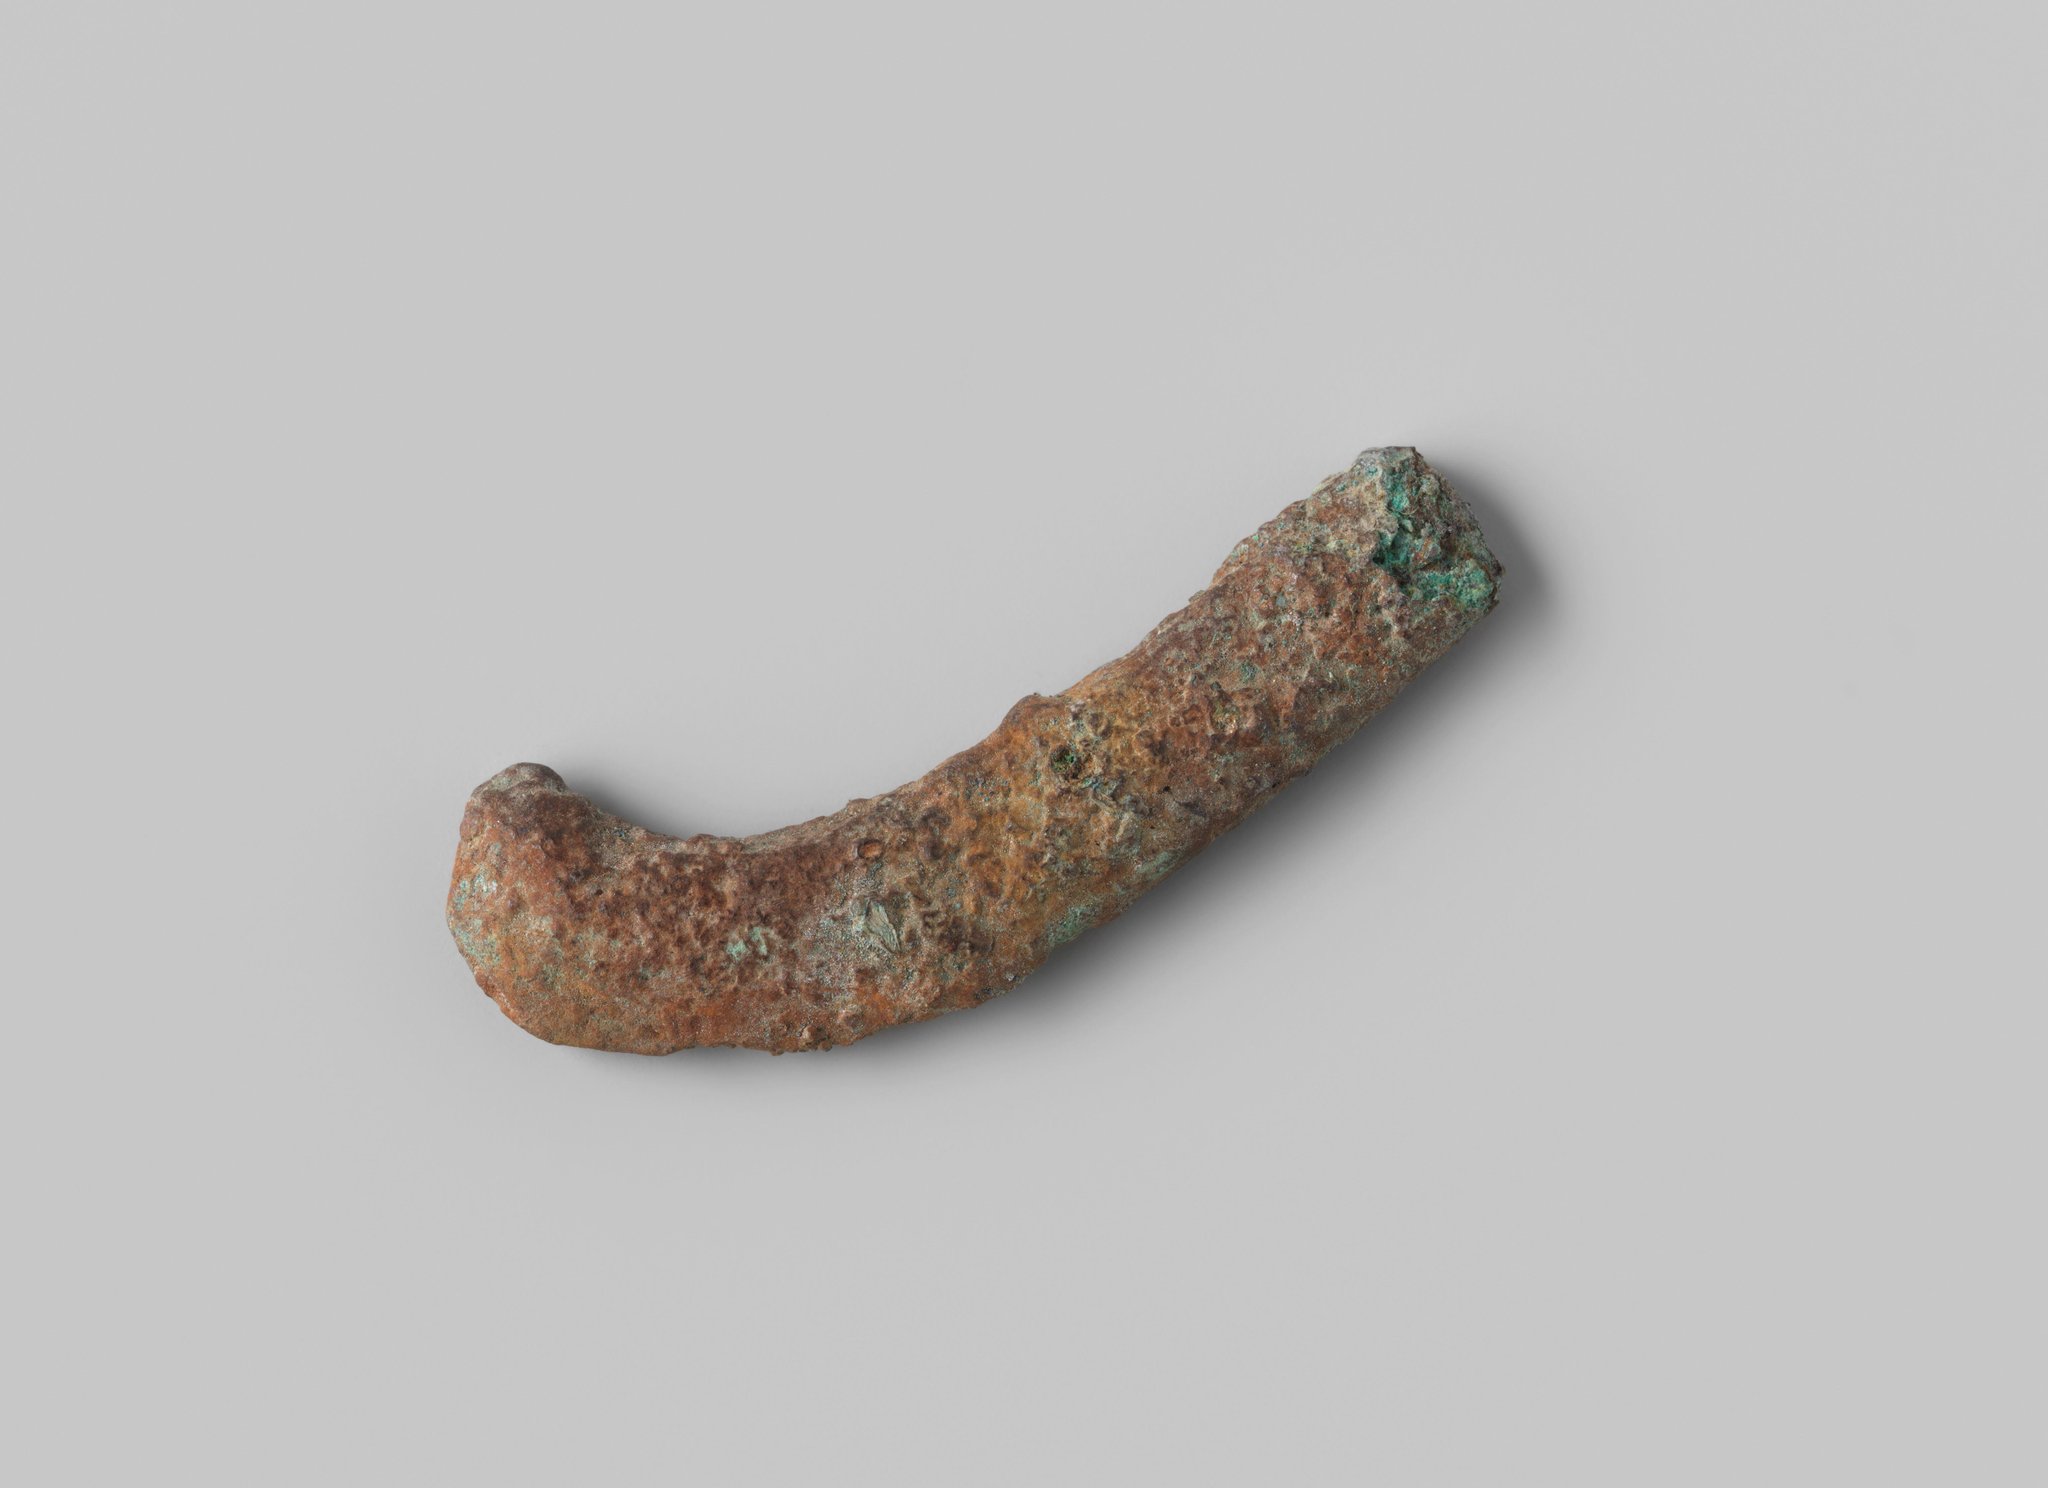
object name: belt buckle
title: Fragment riemgesp uit het wrak van de Oost-Indiëvaarder Hollandia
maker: Anonymous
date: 1700-1743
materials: copper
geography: netherlands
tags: verenigde oostindische compagnie, hollandia (schip), annet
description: Rectangular, fragm of ring, id. NG 1980-27H2852, belt buckle.